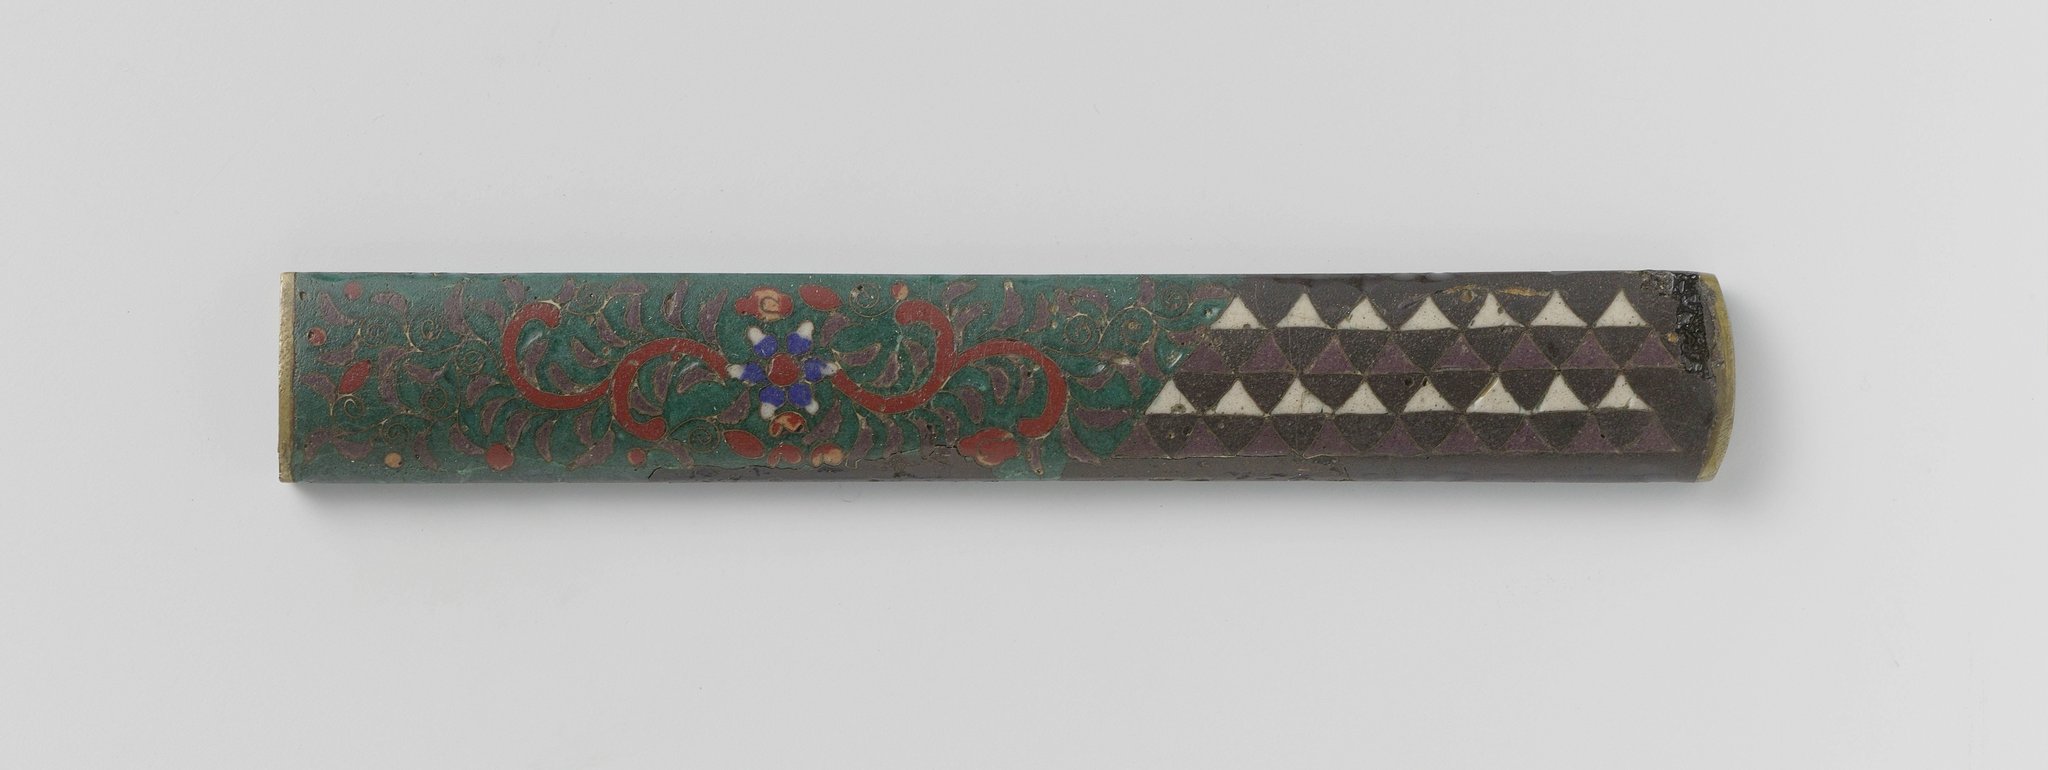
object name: zwaardmesheft, kozuka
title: Sword knife hilt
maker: Anonymous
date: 1500-1900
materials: iron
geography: japan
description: Versiering in cloisonné: iets meer dan één derde deel wordt in besslag genomen door een geometrisch patroon van witte en bruine driehoekjes; de rest door florale motieven in o.a. rood, donkergroen en blauw.